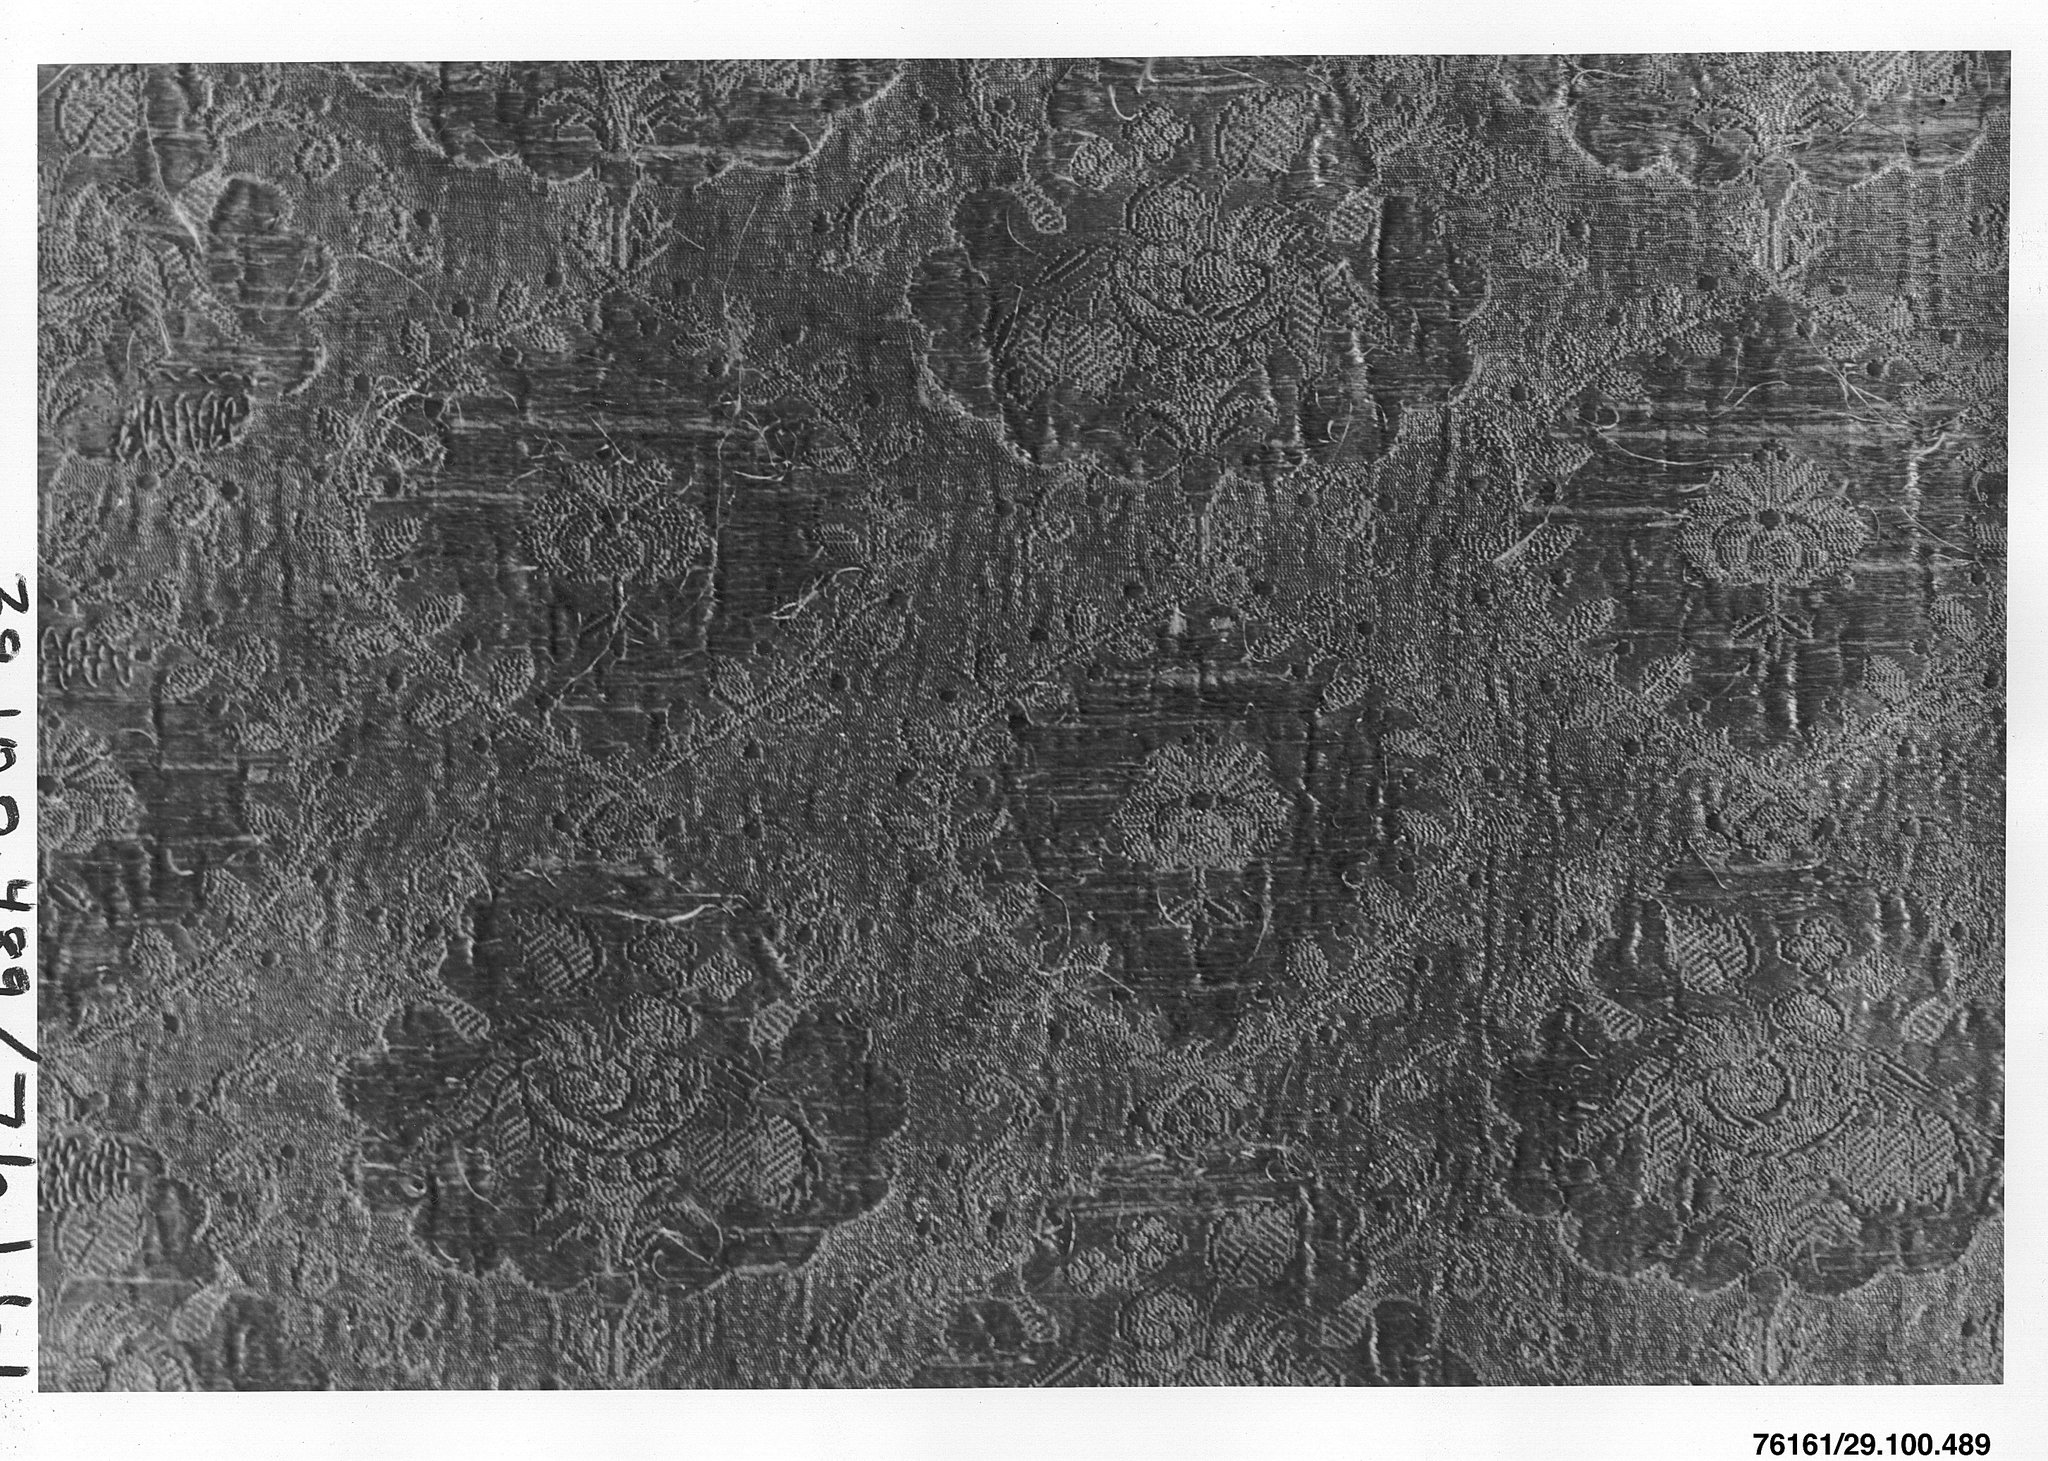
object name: piece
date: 1701-1800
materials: metal thread, silk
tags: flowers